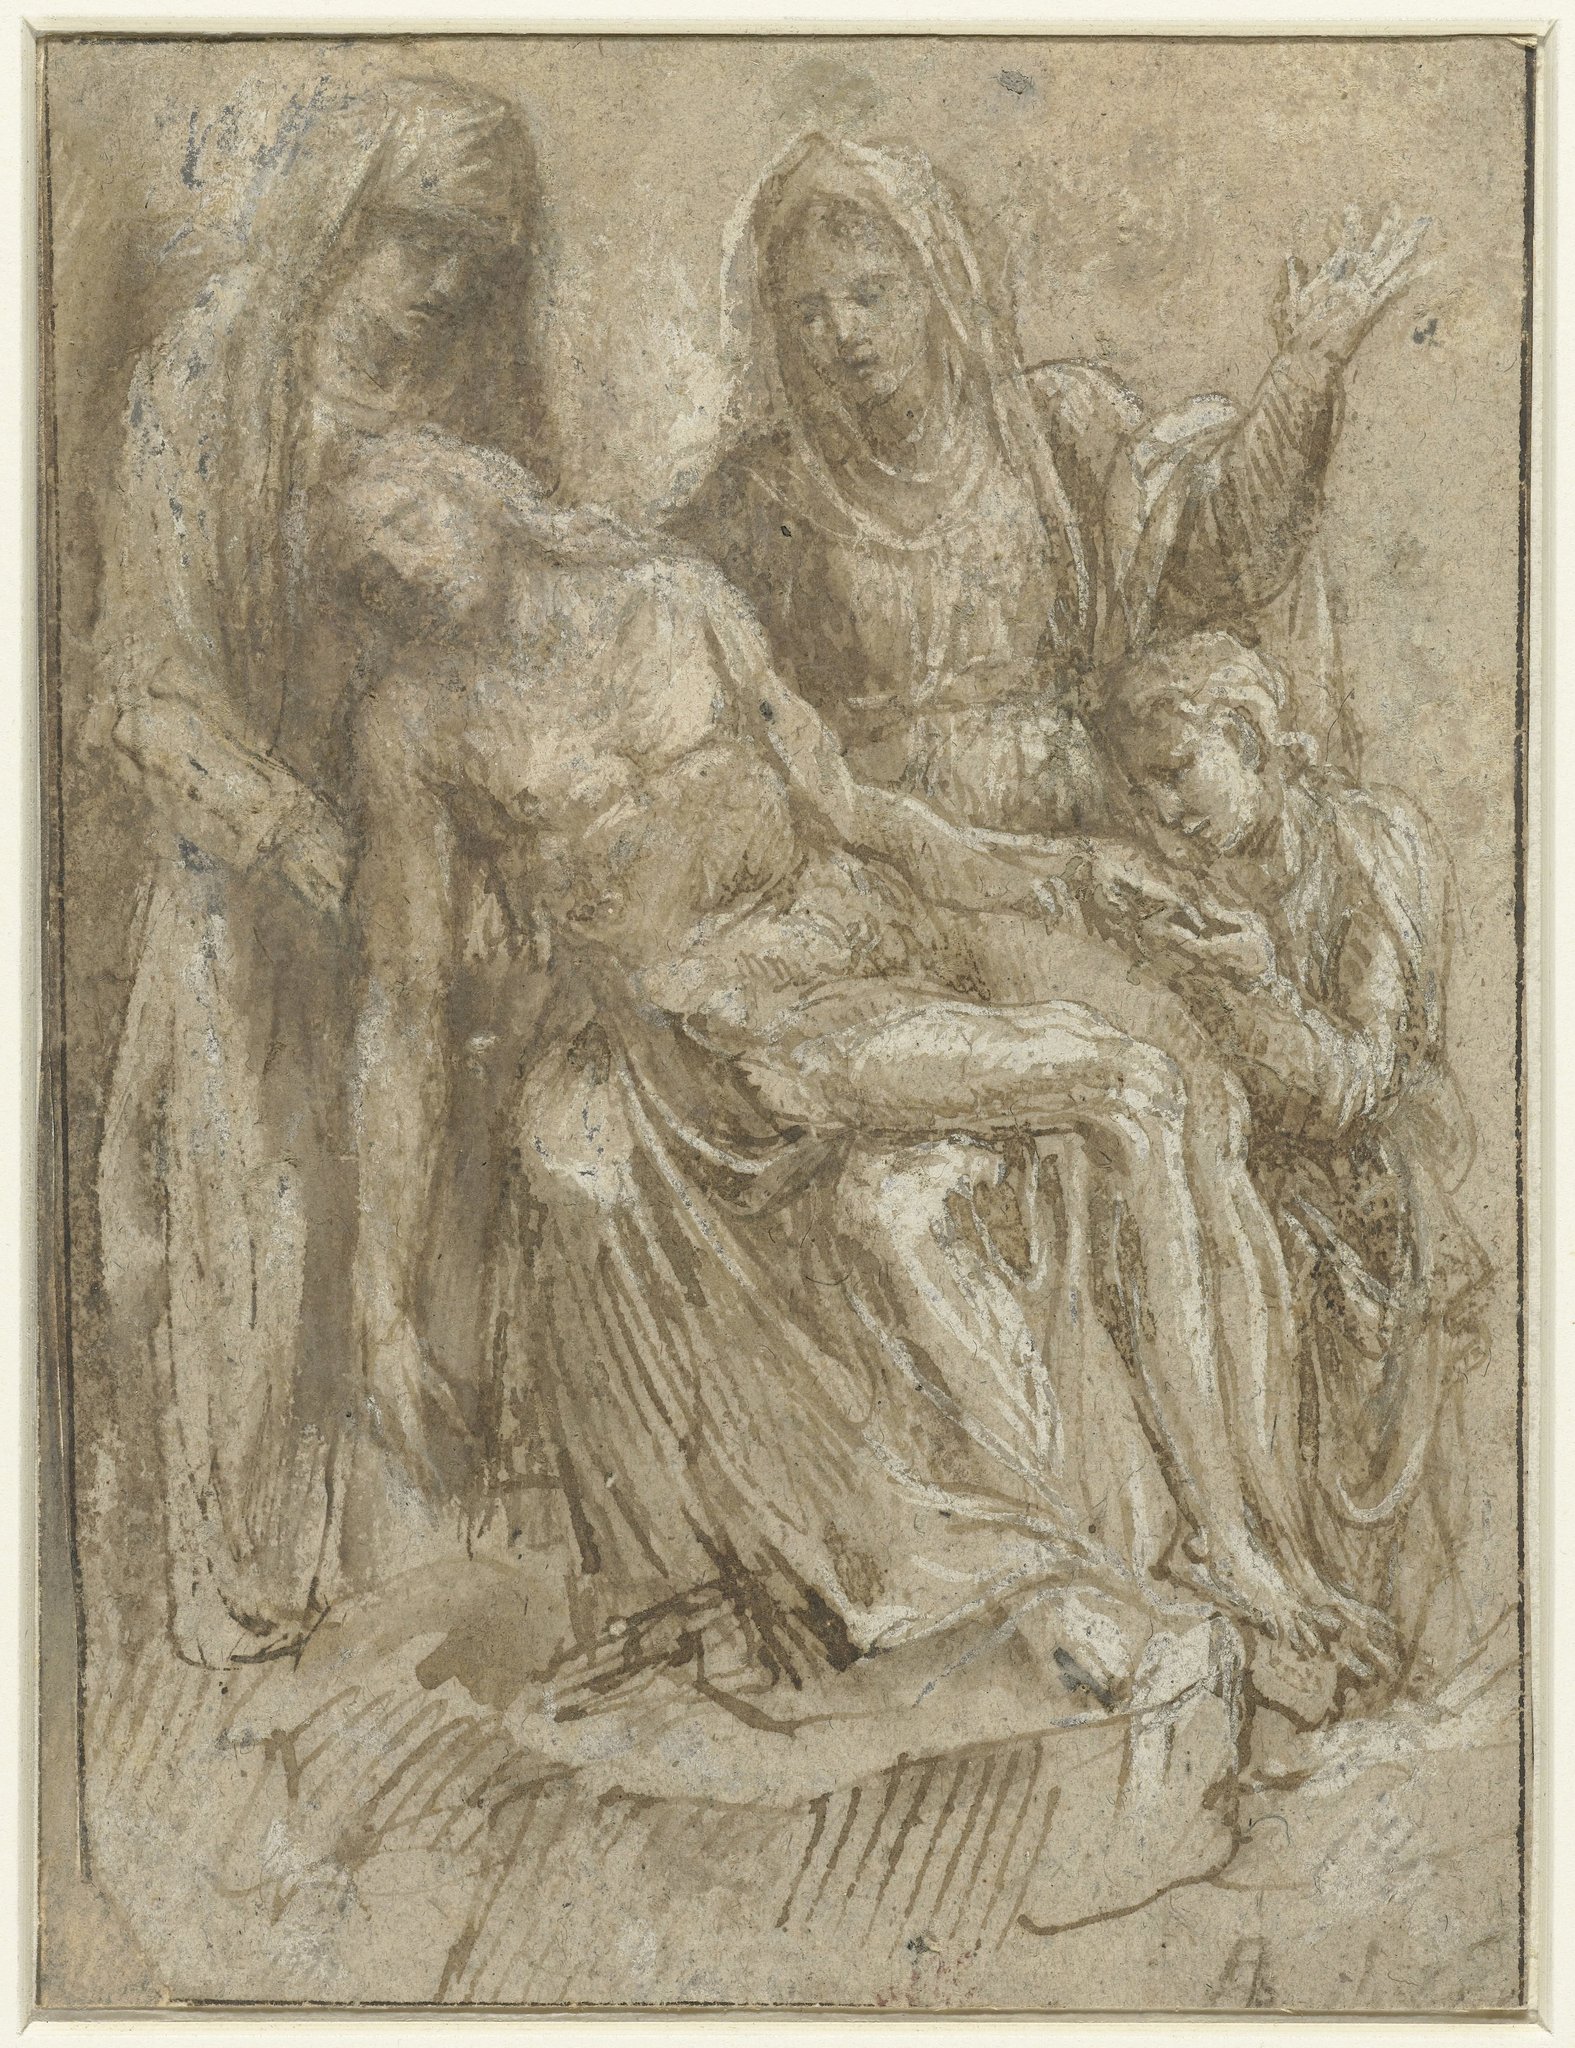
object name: drawing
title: Piëta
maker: biagio puppini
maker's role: draughtsman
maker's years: 1510-1591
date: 1521-1580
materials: ink, paper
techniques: brush, pen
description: Christus beweend door Maria, Maria Magdalena en Johannes.